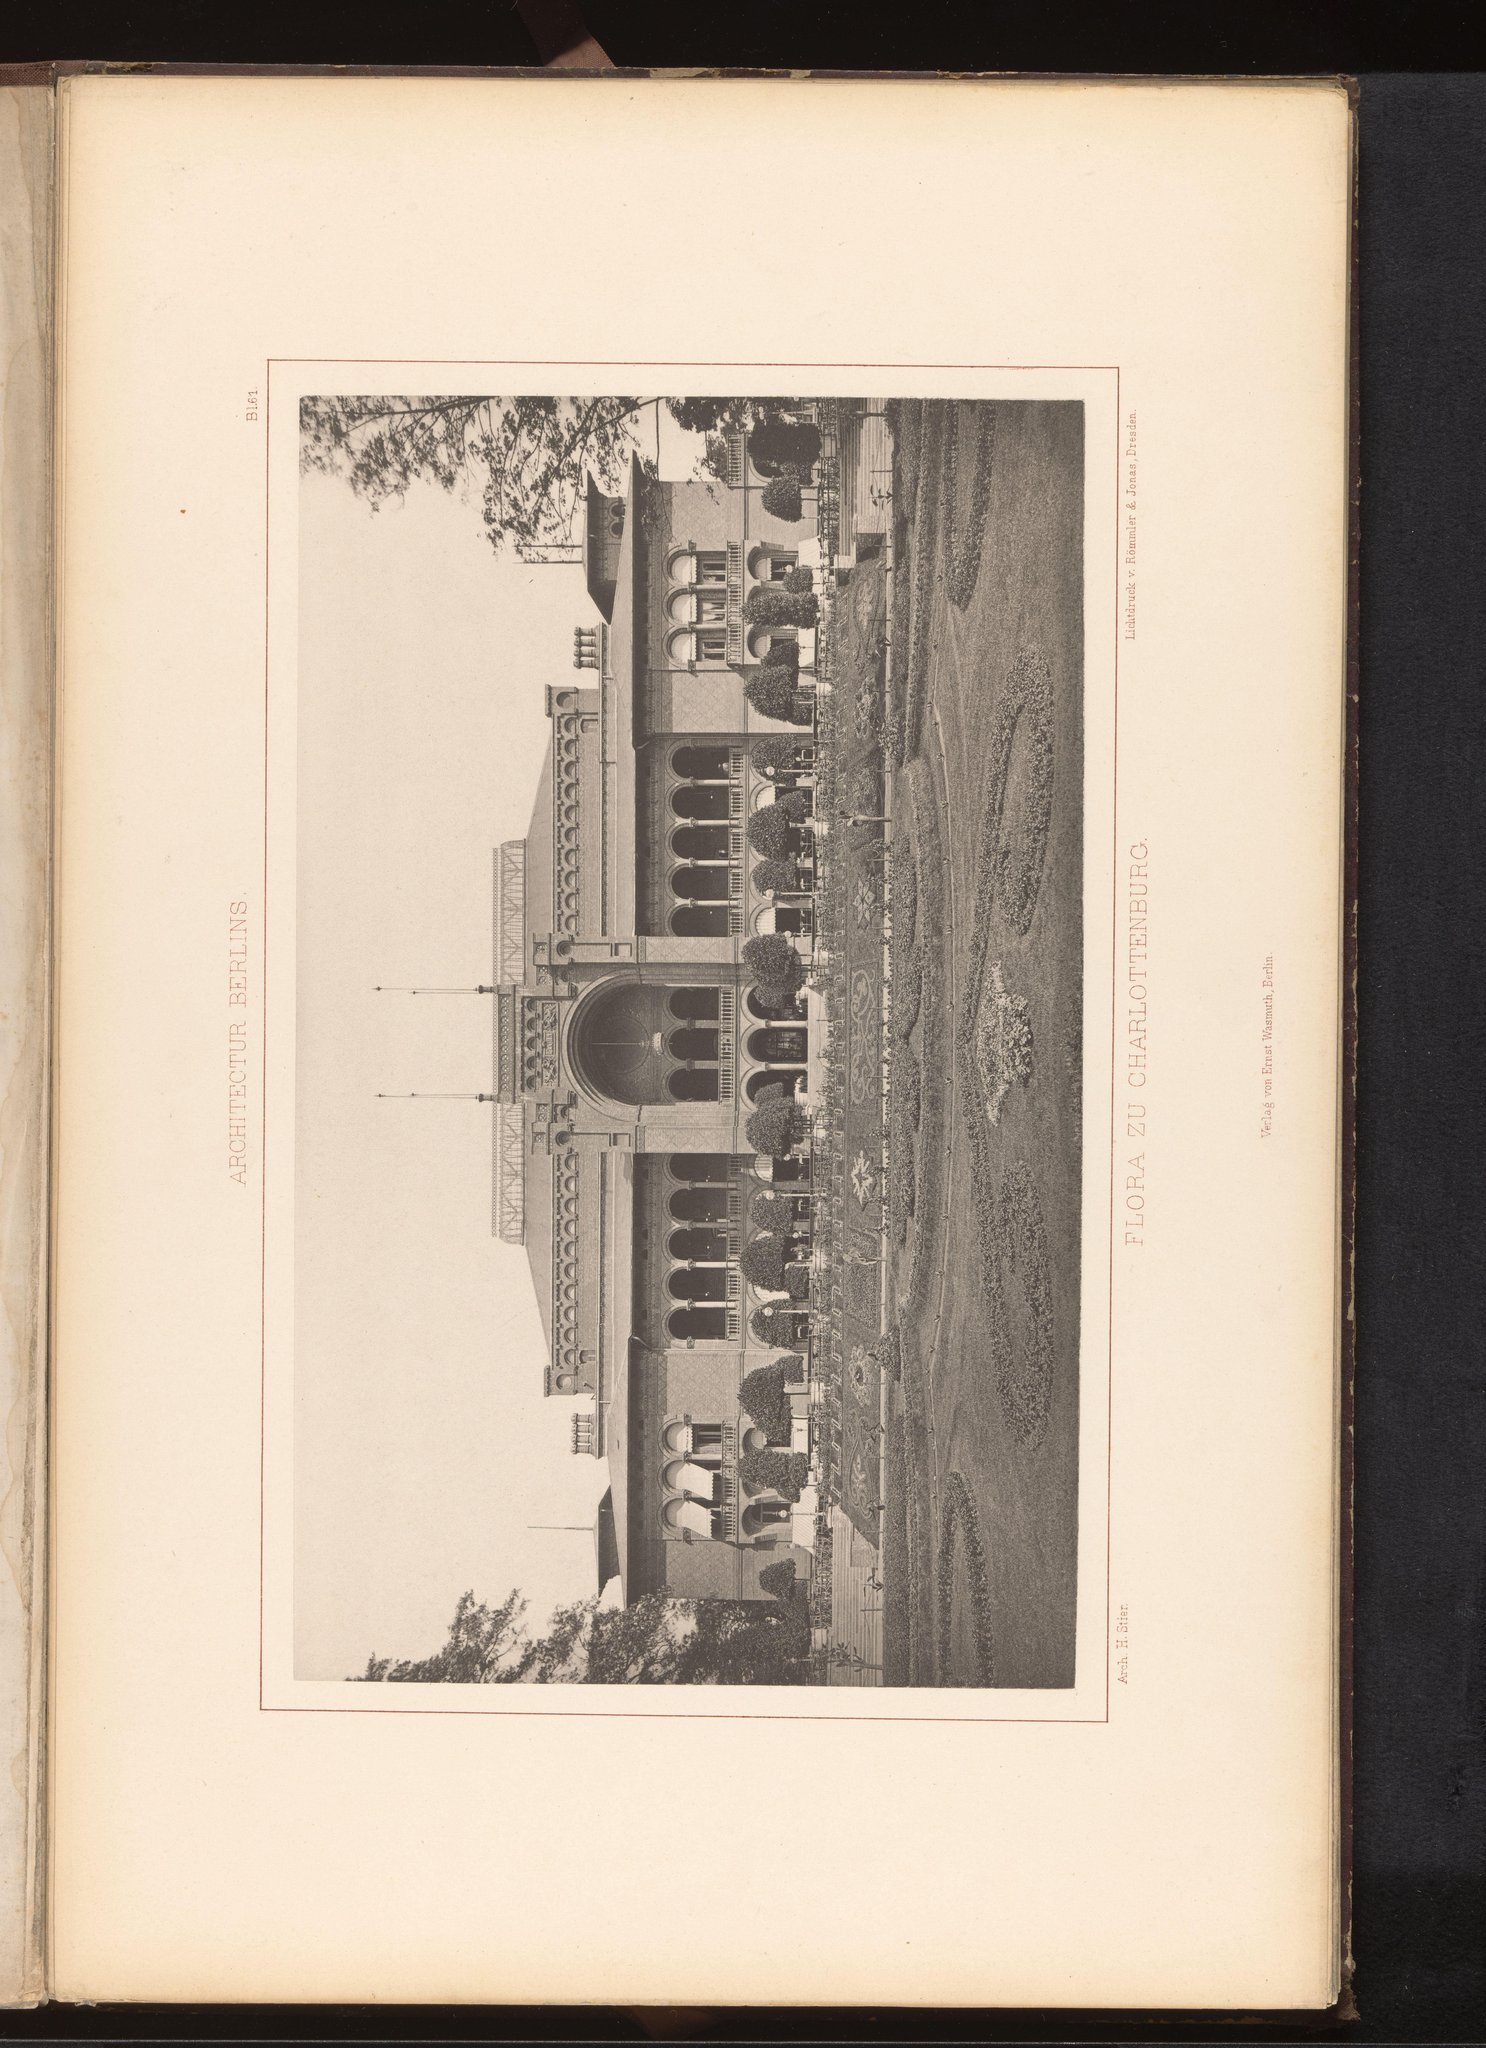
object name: photomechanical print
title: Architectur Berlins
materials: paper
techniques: photograph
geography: berlin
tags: urban housing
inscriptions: number: ‘Bl. 61.’, inscription: ‘Arch. H. Stier.’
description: Deze prent maakt deel uit van een omslag met honderd prenten en zes tekstbladen.